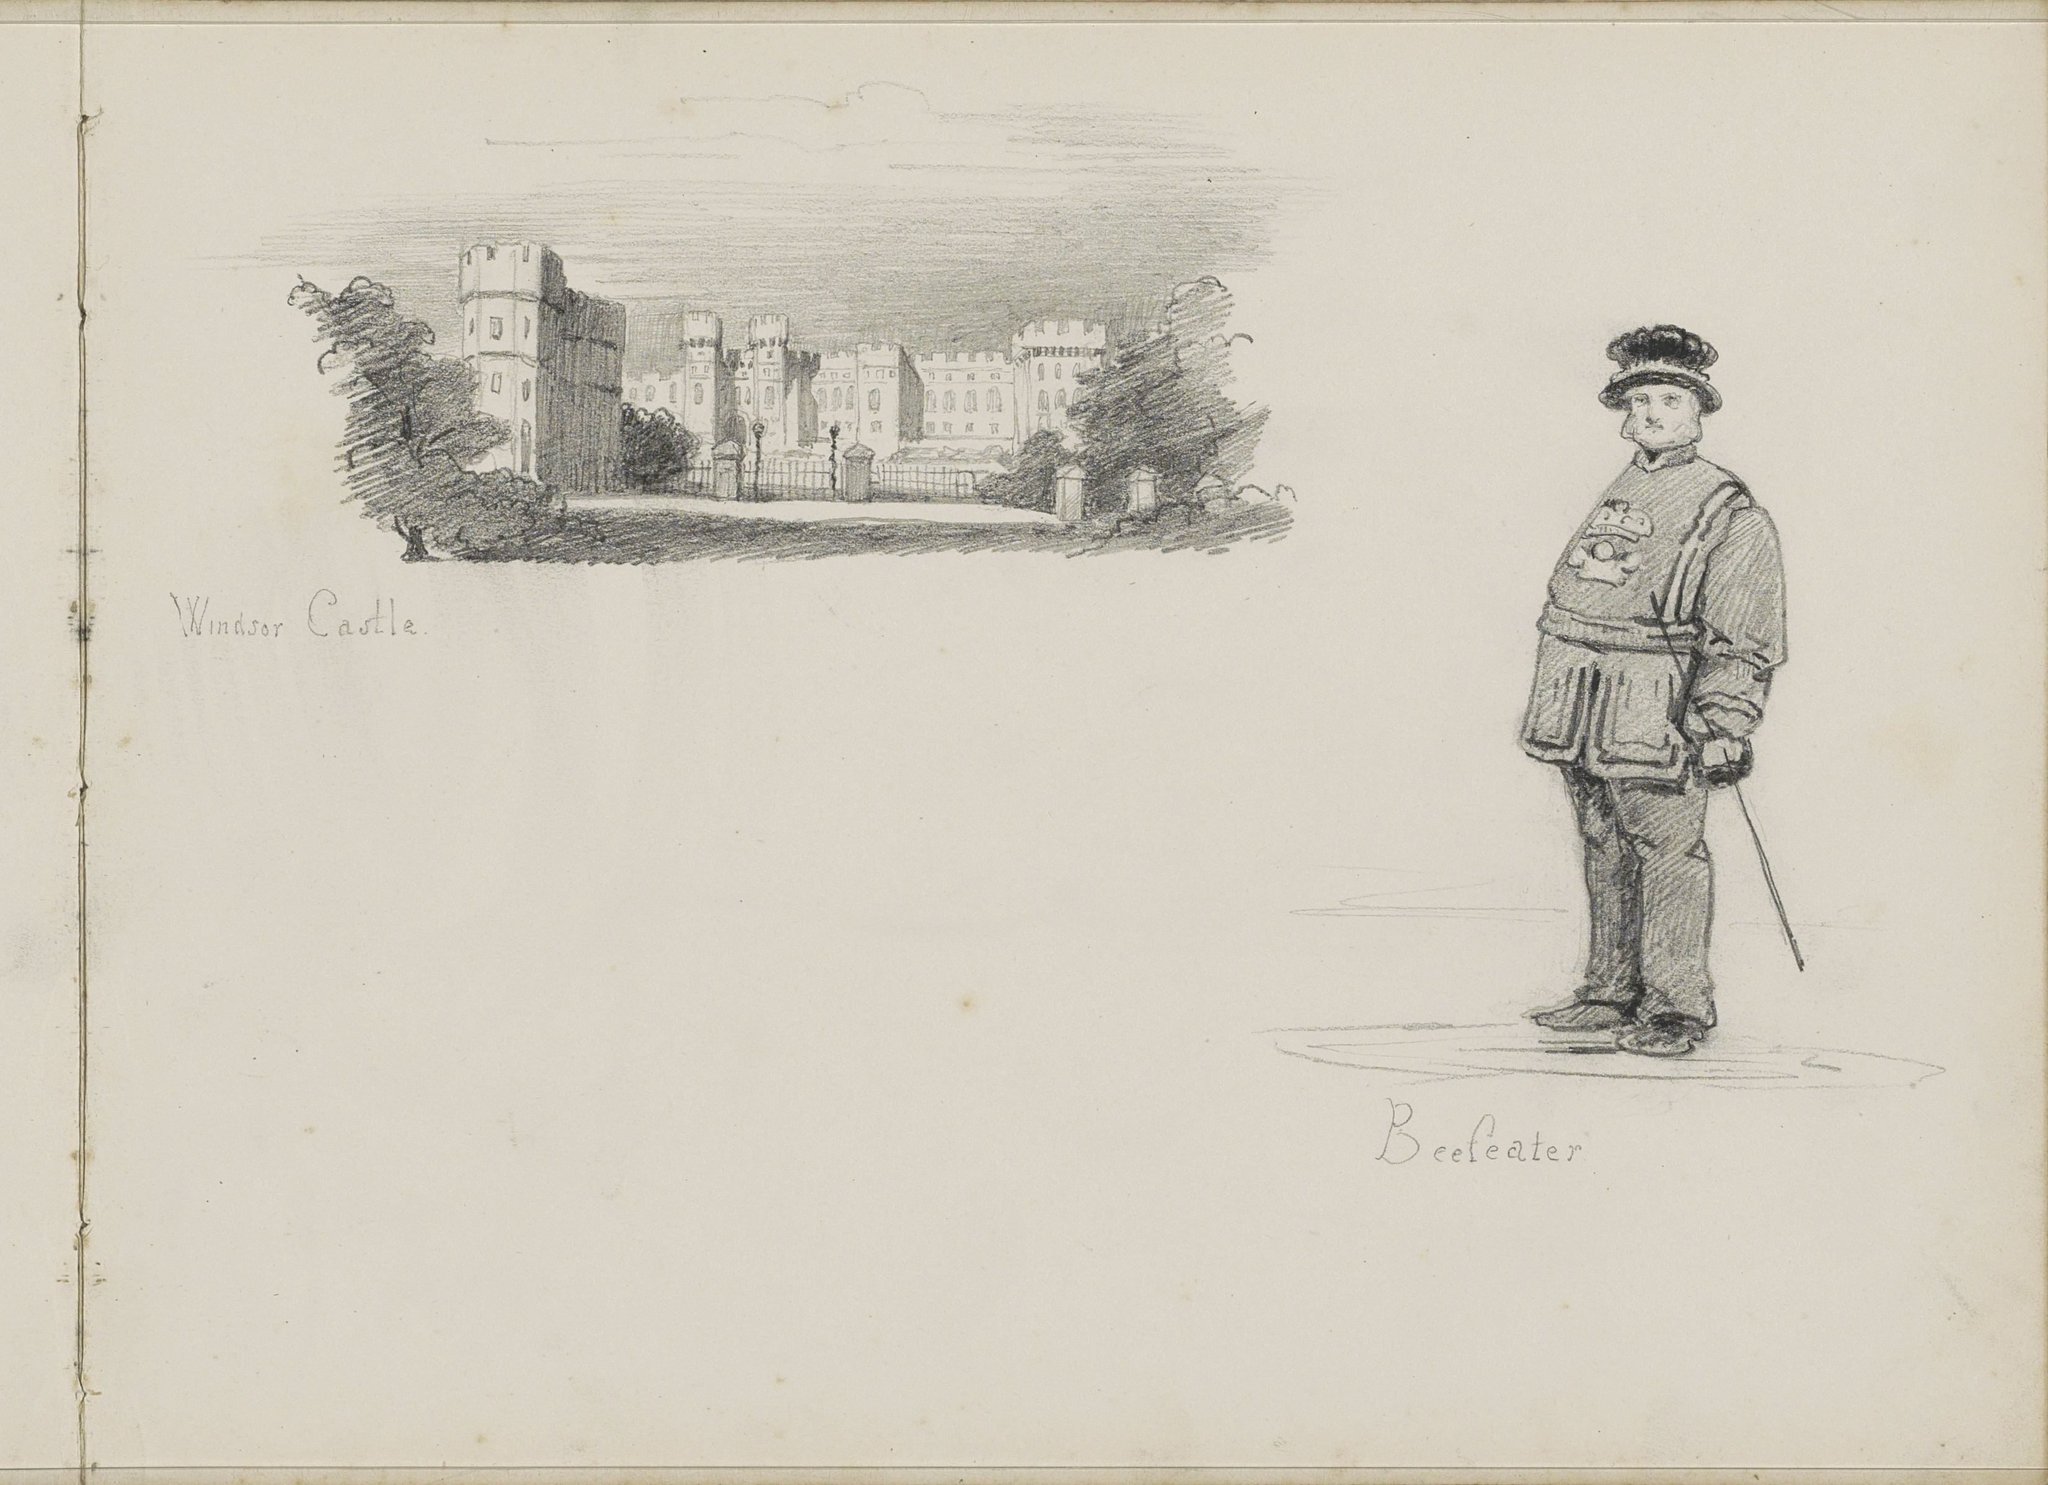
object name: sketchbook leaf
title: Windsor Castle en een bewaker van het Koninklijk Paleis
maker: gerrit postma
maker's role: draughtsman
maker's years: 1819-1894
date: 1858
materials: paper, pencil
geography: windsor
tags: castle, palace, guard duty, keeping sentry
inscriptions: annotation: ‘Windsor Castle./ Beefeater’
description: Blad 45 recto uit een schetsboek met 52 bladen.